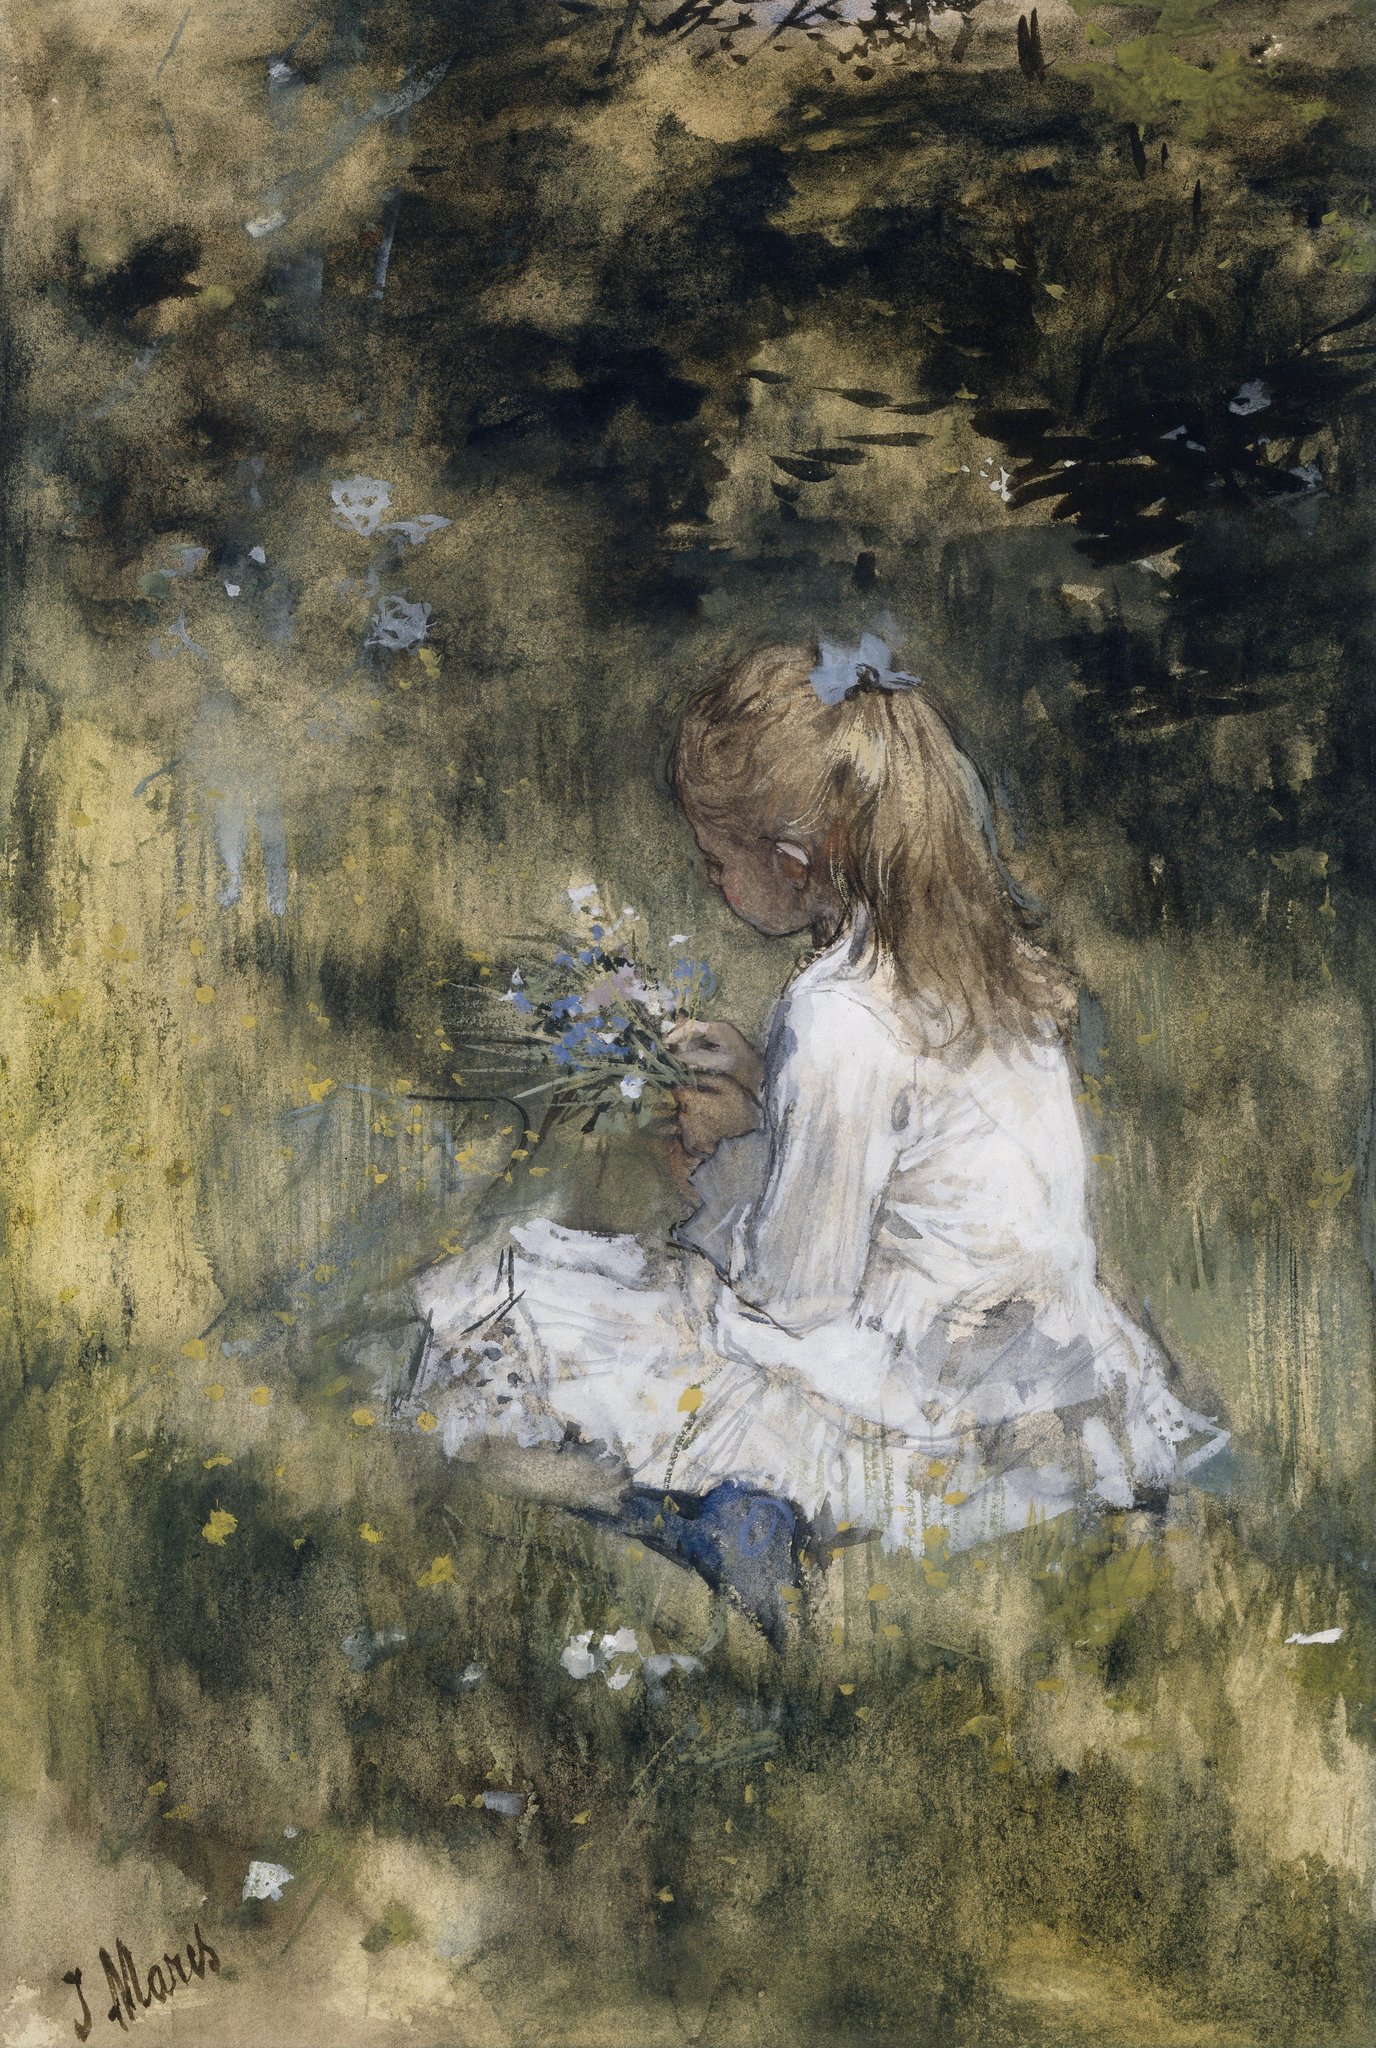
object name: drawing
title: A Girl with Flowers on the Grass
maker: jacob maris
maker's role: draughtsman, painter, print maker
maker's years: 1837-1899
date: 1878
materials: chalk, paper, watercolor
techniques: brush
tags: flowers, girl (child between toddler and youth), child and nature (games and plays)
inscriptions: signature: ‘J Maris’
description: A girl in a white dress, viewed from the side, is sitting on the grass holding a bouquet of wild flowers. The blue of the flowers is echoed in the bow in her hair and her shoes. It was probably one of Maris’s daughters who modelled for this idyllic scene. The atmosphere and the style of painting recalls the work of 19th-century French Impressionists such as Claude Monet and veers away from Maris’s usual grey palette.